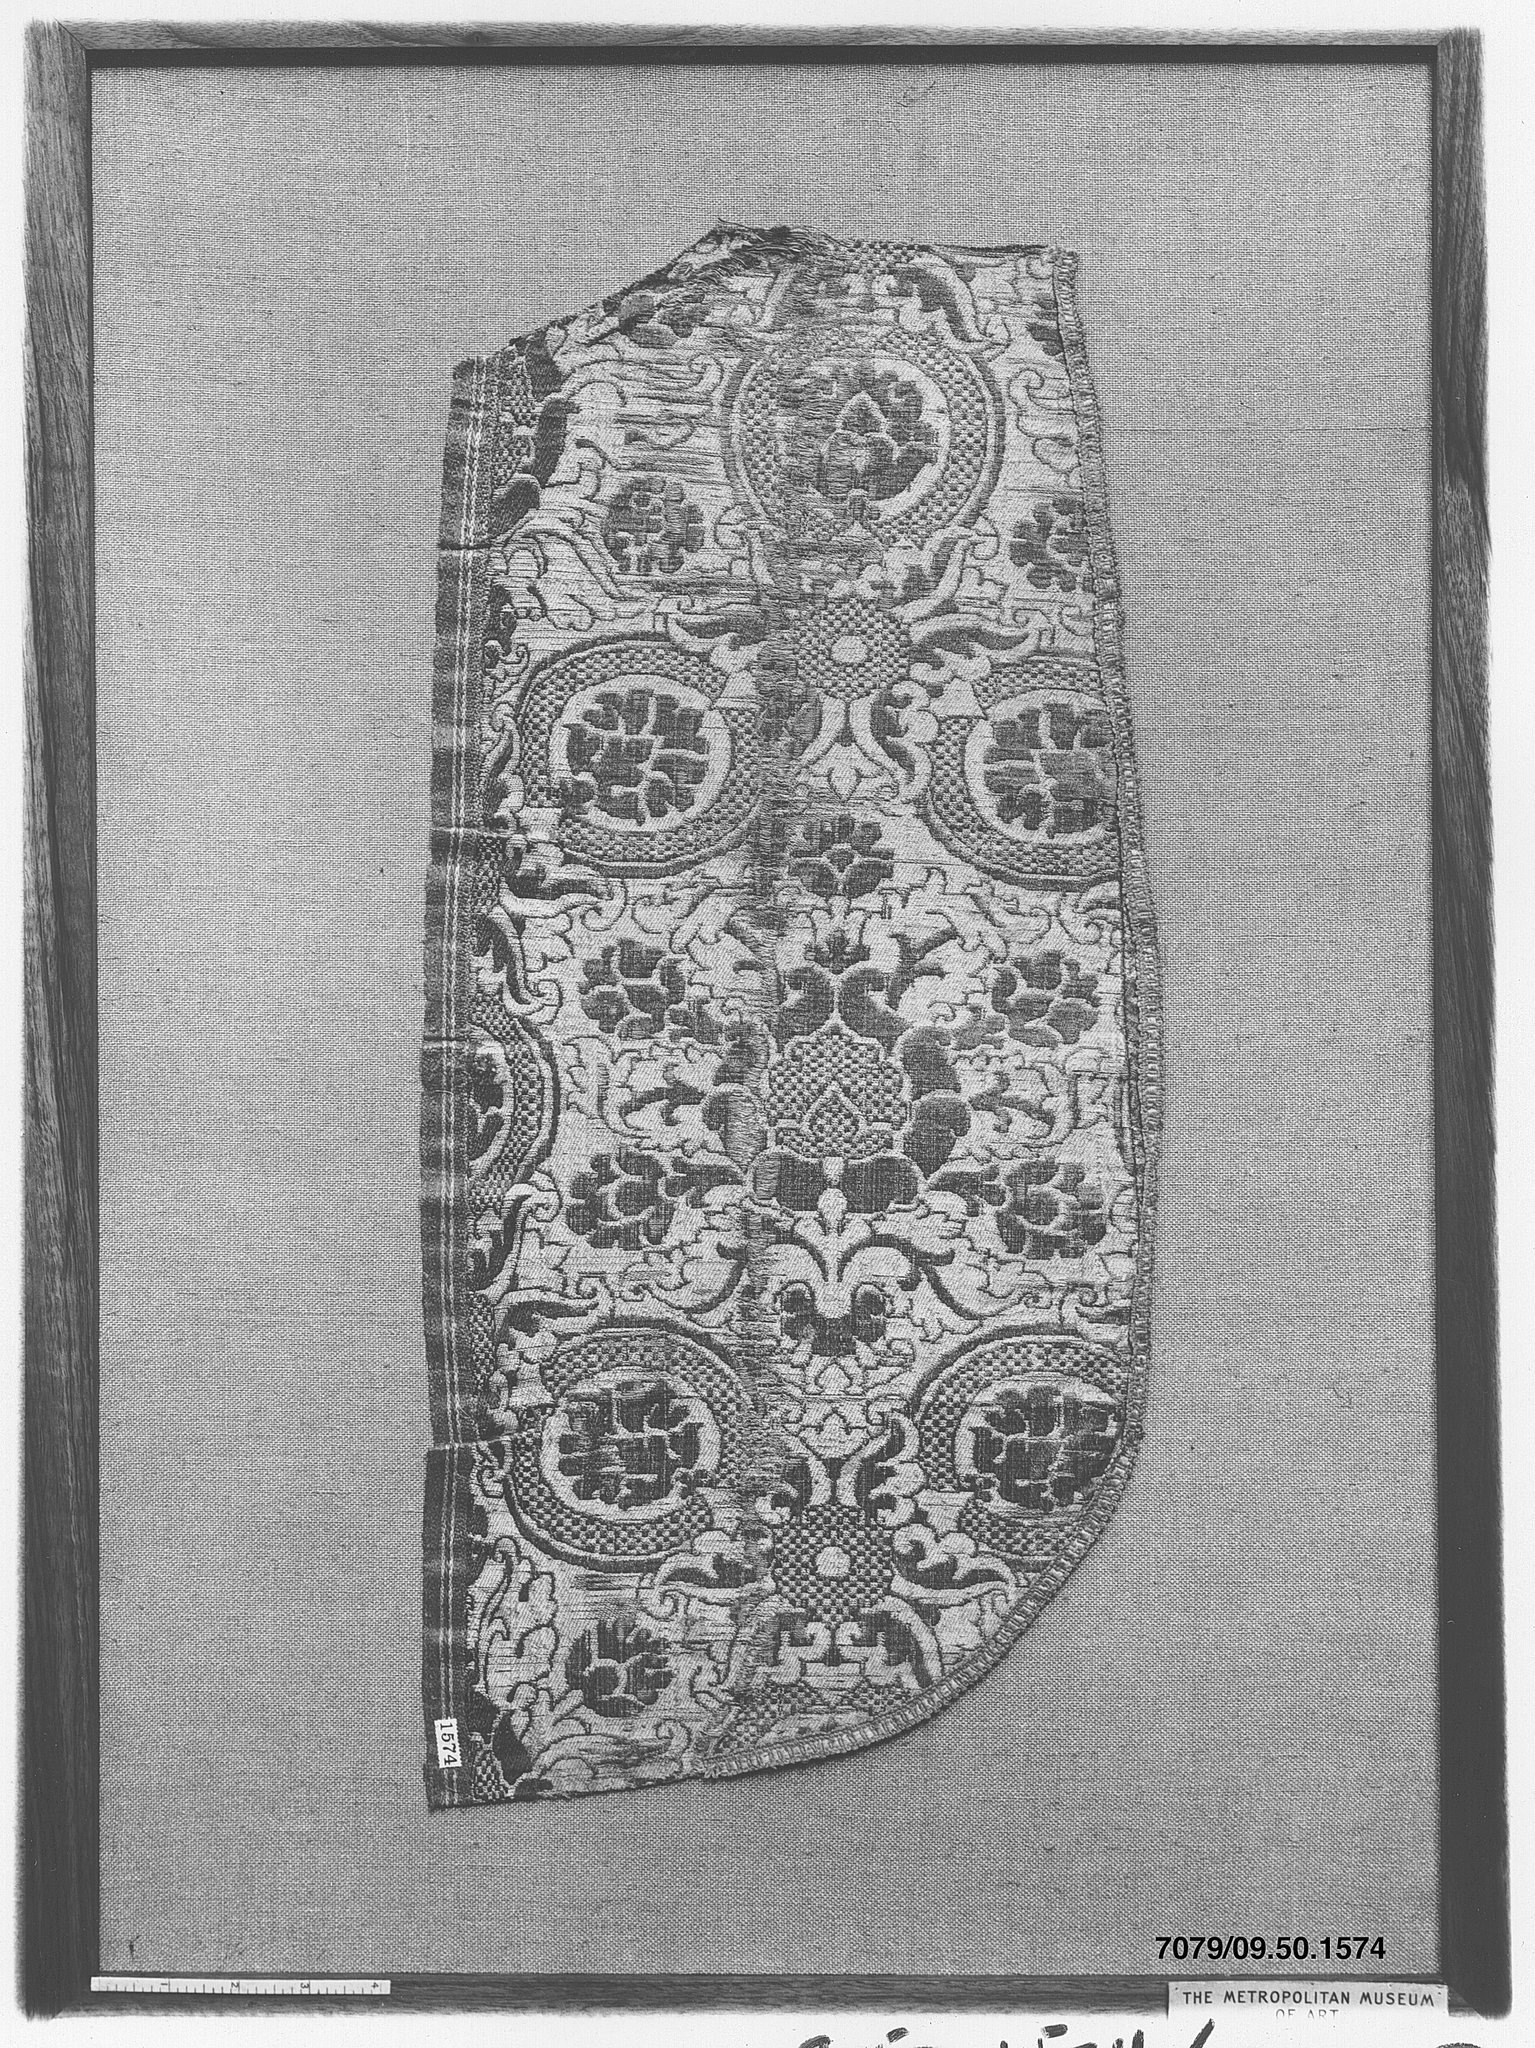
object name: piece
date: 1401-1500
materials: hemp, silk